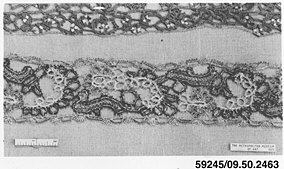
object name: passementerie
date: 1501-1600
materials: silk